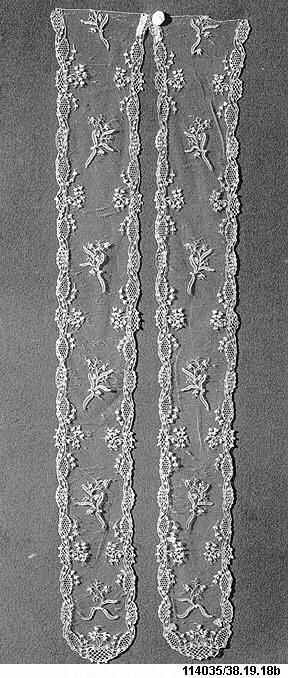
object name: lappet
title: Pair of lappets (part of a garniture)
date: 1774-1793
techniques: lace